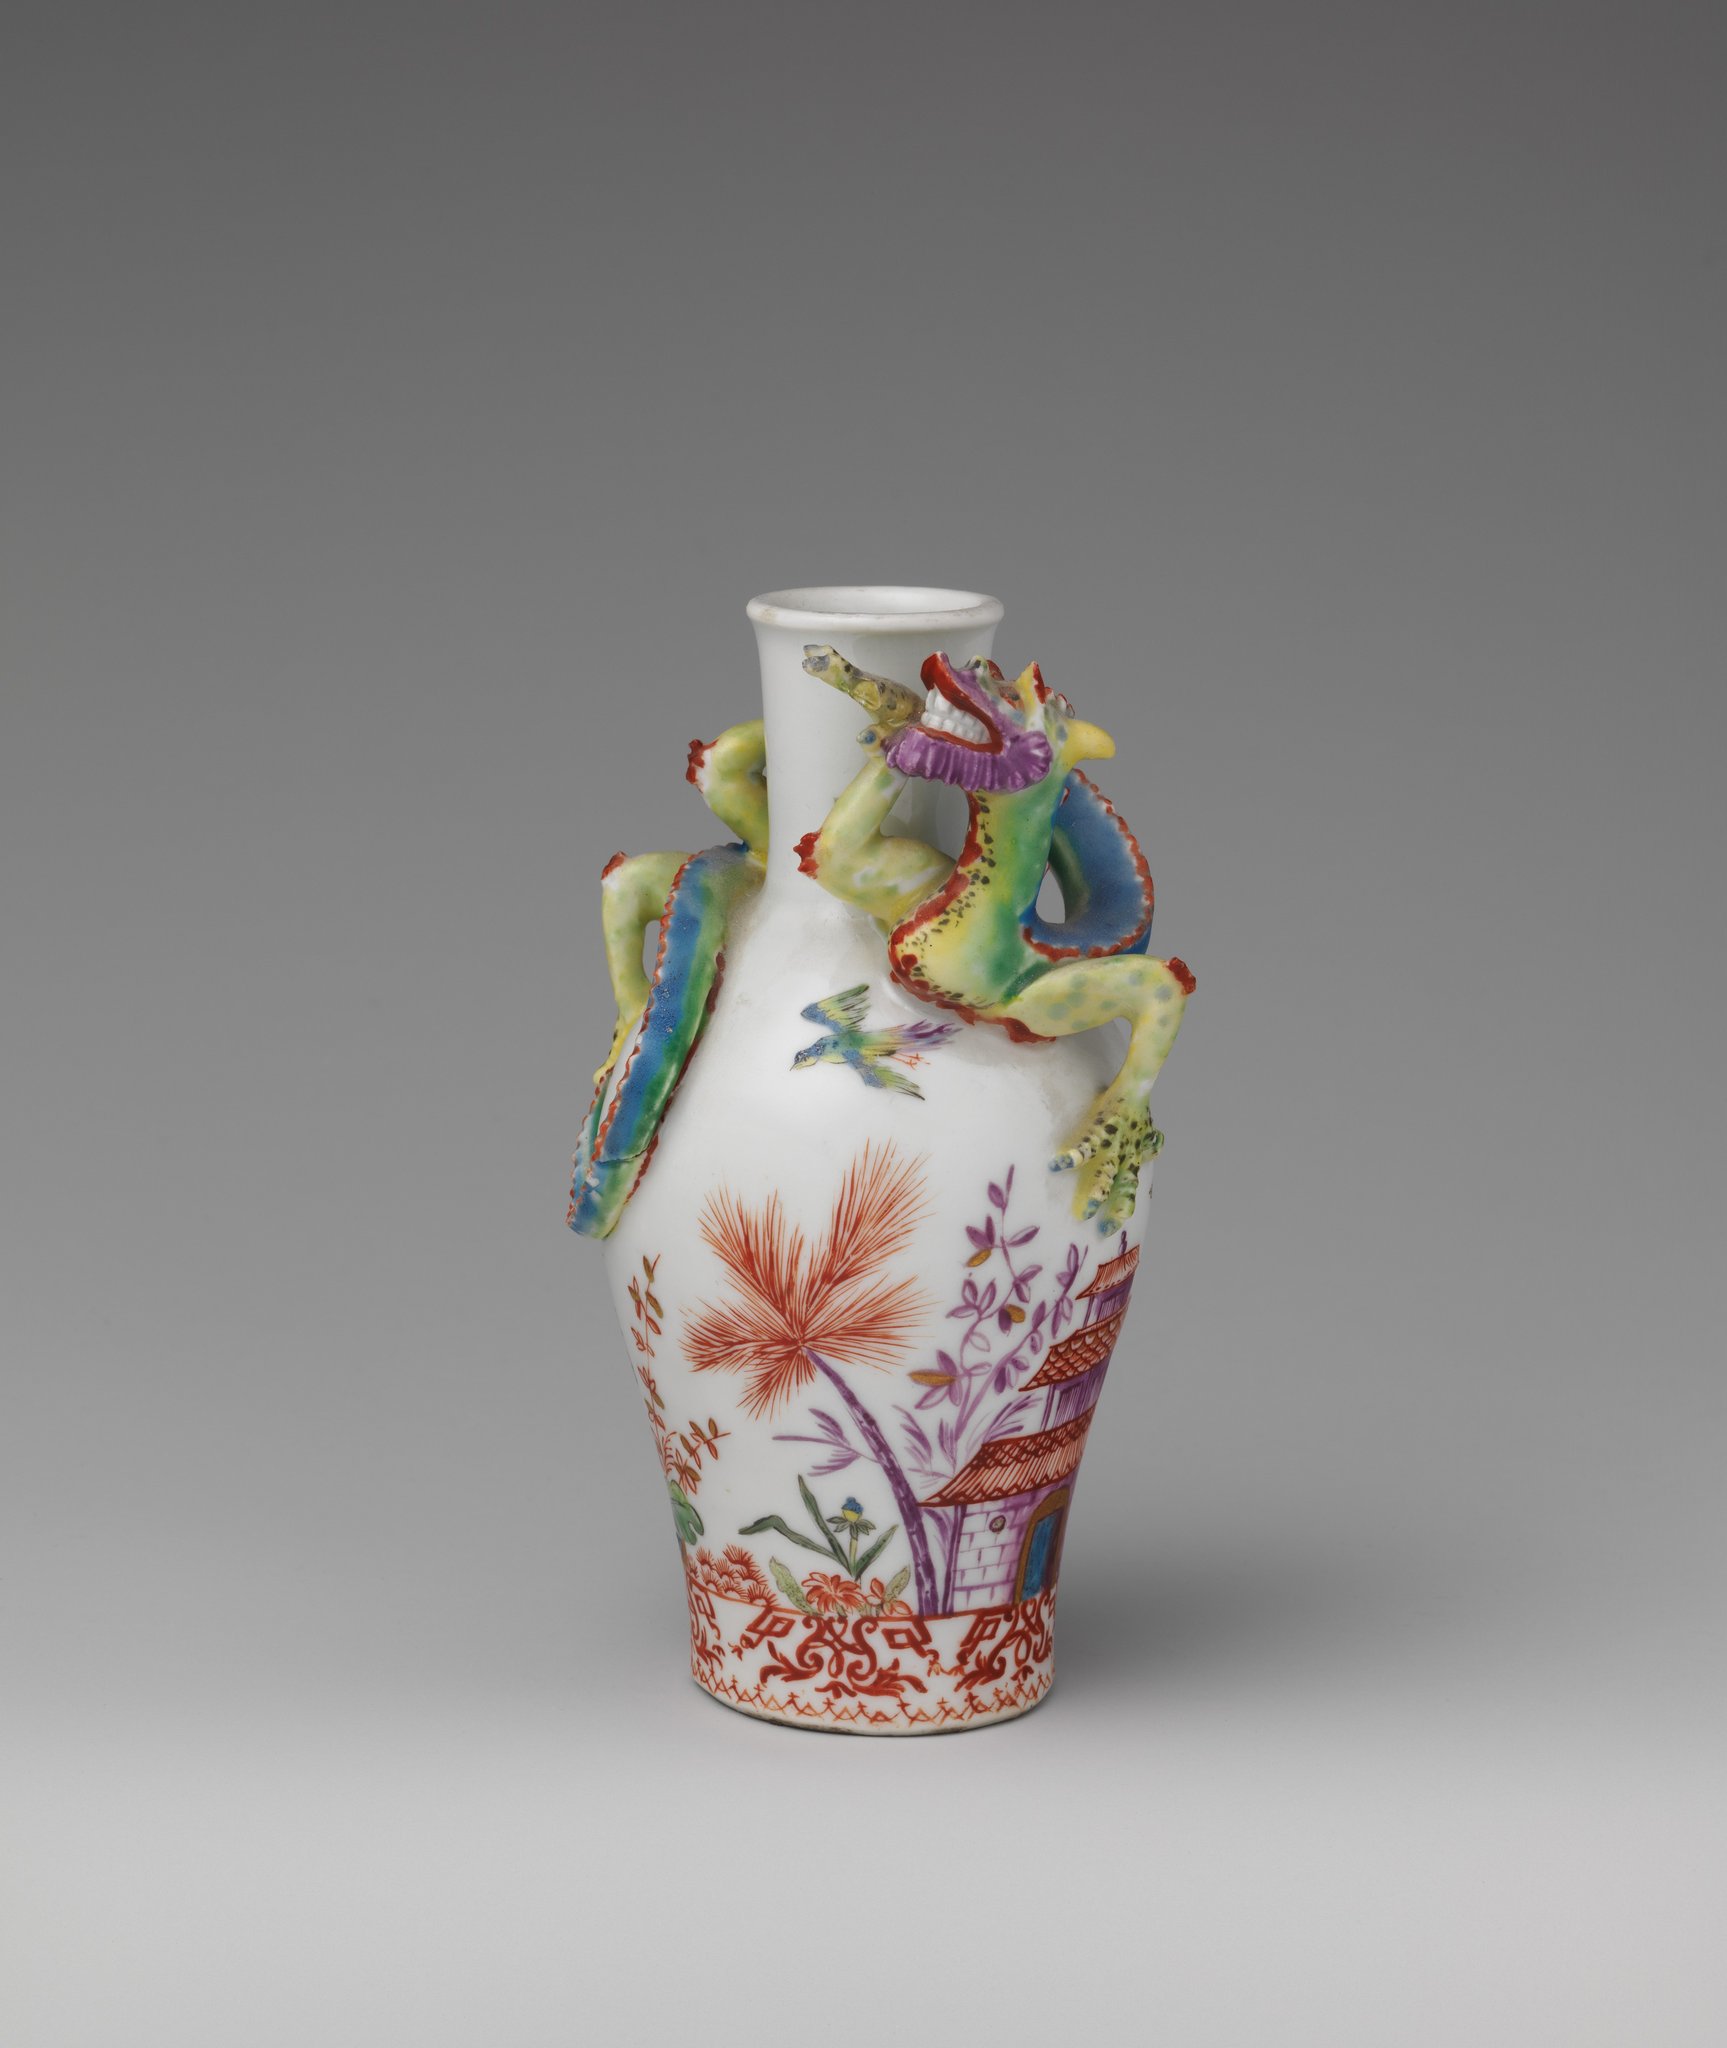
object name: vase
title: Vase (one of a pair)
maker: vienna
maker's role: manufactory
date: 1730-1740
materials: hard paste porcelain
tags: birds,houses,dragons